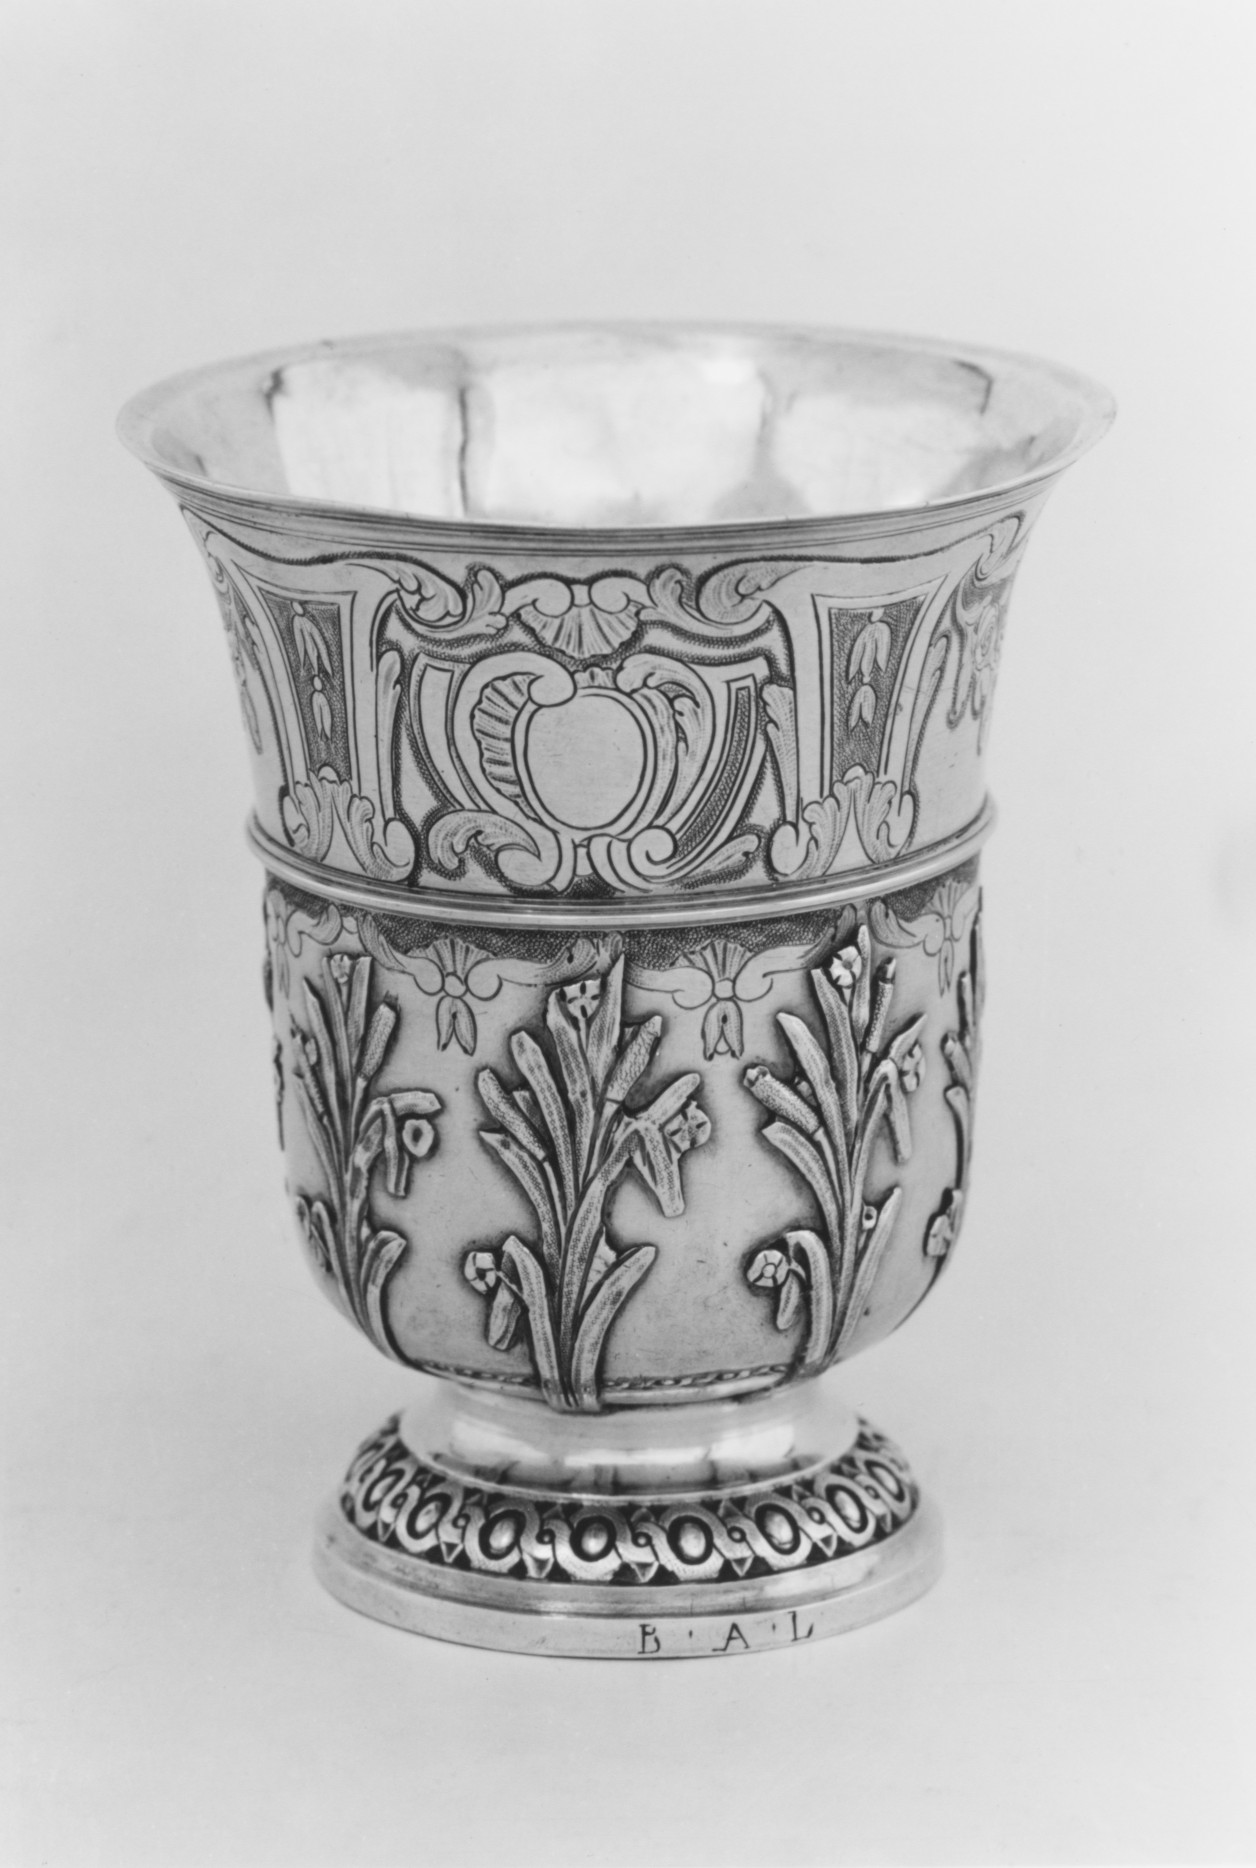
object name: beaker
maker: antoine bailly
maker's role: maker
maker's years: 1665-1765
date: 1763-1764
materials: silver